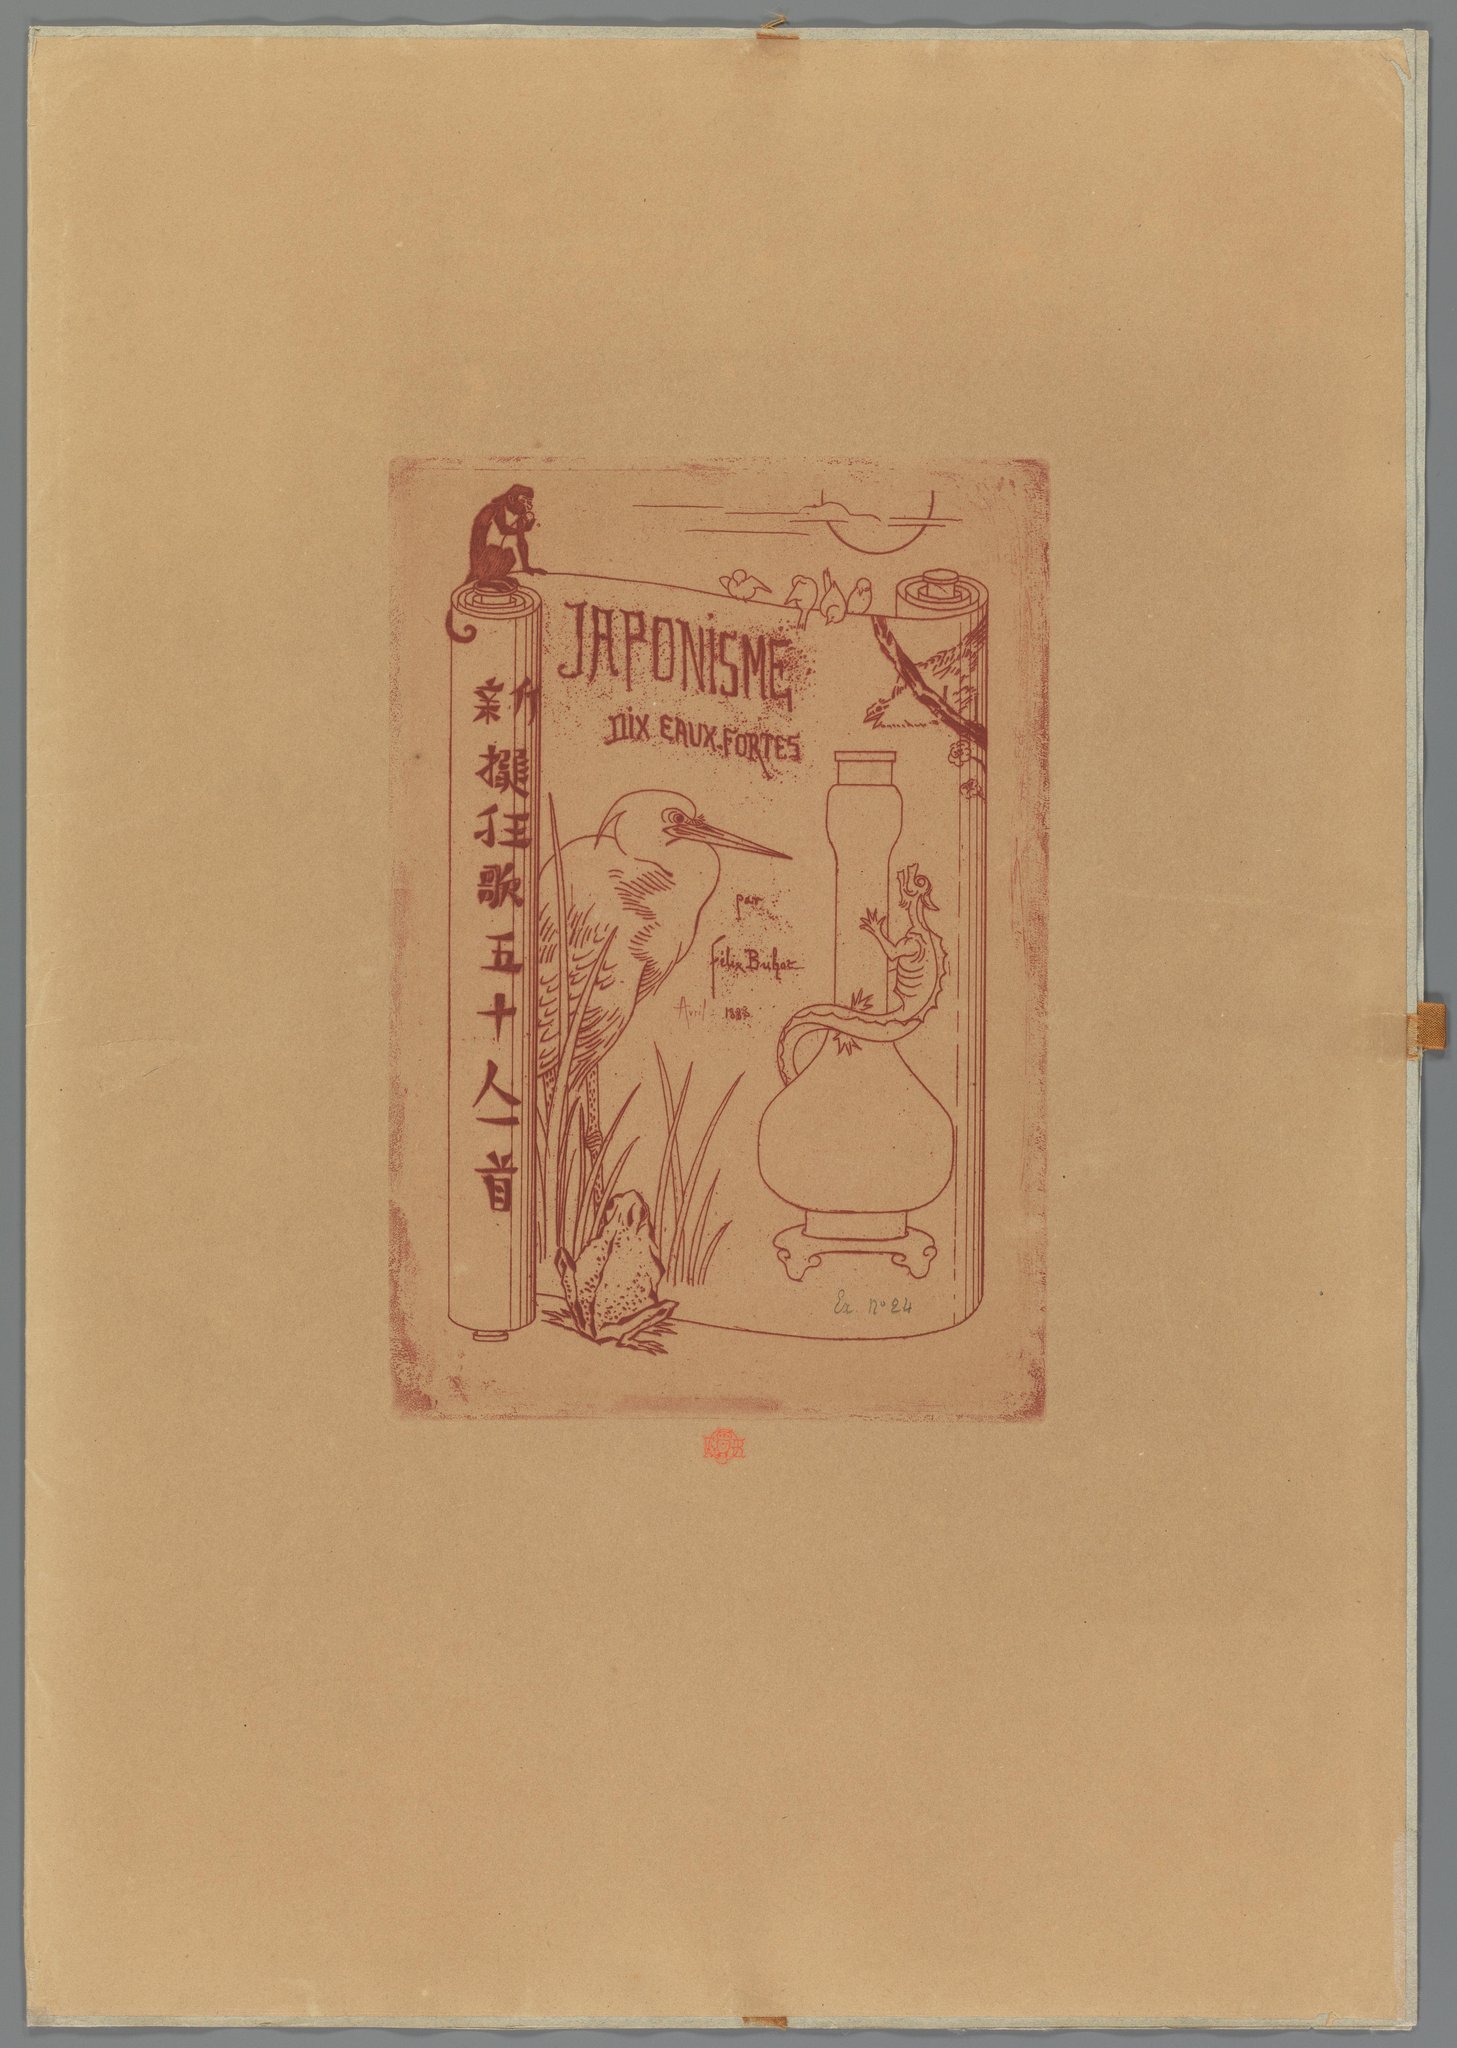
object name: titelprent, frontispice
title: Boekrol met daarop een kraanvogel, vaas met hagedis en kikker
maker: félix hilaire buhot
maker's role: draughtsman, print maker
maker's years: 1847-1898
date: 1883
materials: paper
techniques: drypoint, etching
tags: shore-birds and wading-birds: crane, lizards, tailless amphibians: toad, scroll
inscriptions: inscription: ‘Ex. no 24’, stamp: Lugt 977, collector's mark: Lugt 2233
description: Recto van een tweede omslag, bij elkaar gebonden met een okerkleurig lint met op de voorkant de titelprent gedruk in rood en op de achterzijde de ex libris in paars. In deze omslag bevinden zich tien prenten van de serie "Japonisme. Dix Eaux-Fortes". Deze omslag bevindt zich in een andere omslag met dezelfde prenten op de voor- en achterkant gedrukt in zwart. De serie bestaat uit acht platen plus titelprent en ex libris, naar Japanse objecten uit de collectie van Philippe Burty, uitgegeven in Parijs door Edmond Sagot in (april) 1883. In dat jaar vond er een belangrijke tentoonstelling plaats evenals andere Japan-georiënteerde activiteiten. Op 10 april 1883 opende de eerste retrospectieve tentoonstelling van Japanse kunst in de Westerse wereld in de Gallery Georges Petit op de Rue de Sèze te Parijs. Volgens een brief van Buhot aan Octave Uzanne, gedateerd 4 april 1883, had Buhot in 1875 reeds negen van de tien platen vervaardigd. Bourcard & Goodfriend vermelden dat er van de serie vijftig waren gedrukt op Japans papier, honderd op Nederlands papier en enkelen op geel met goud bewerkt papier.